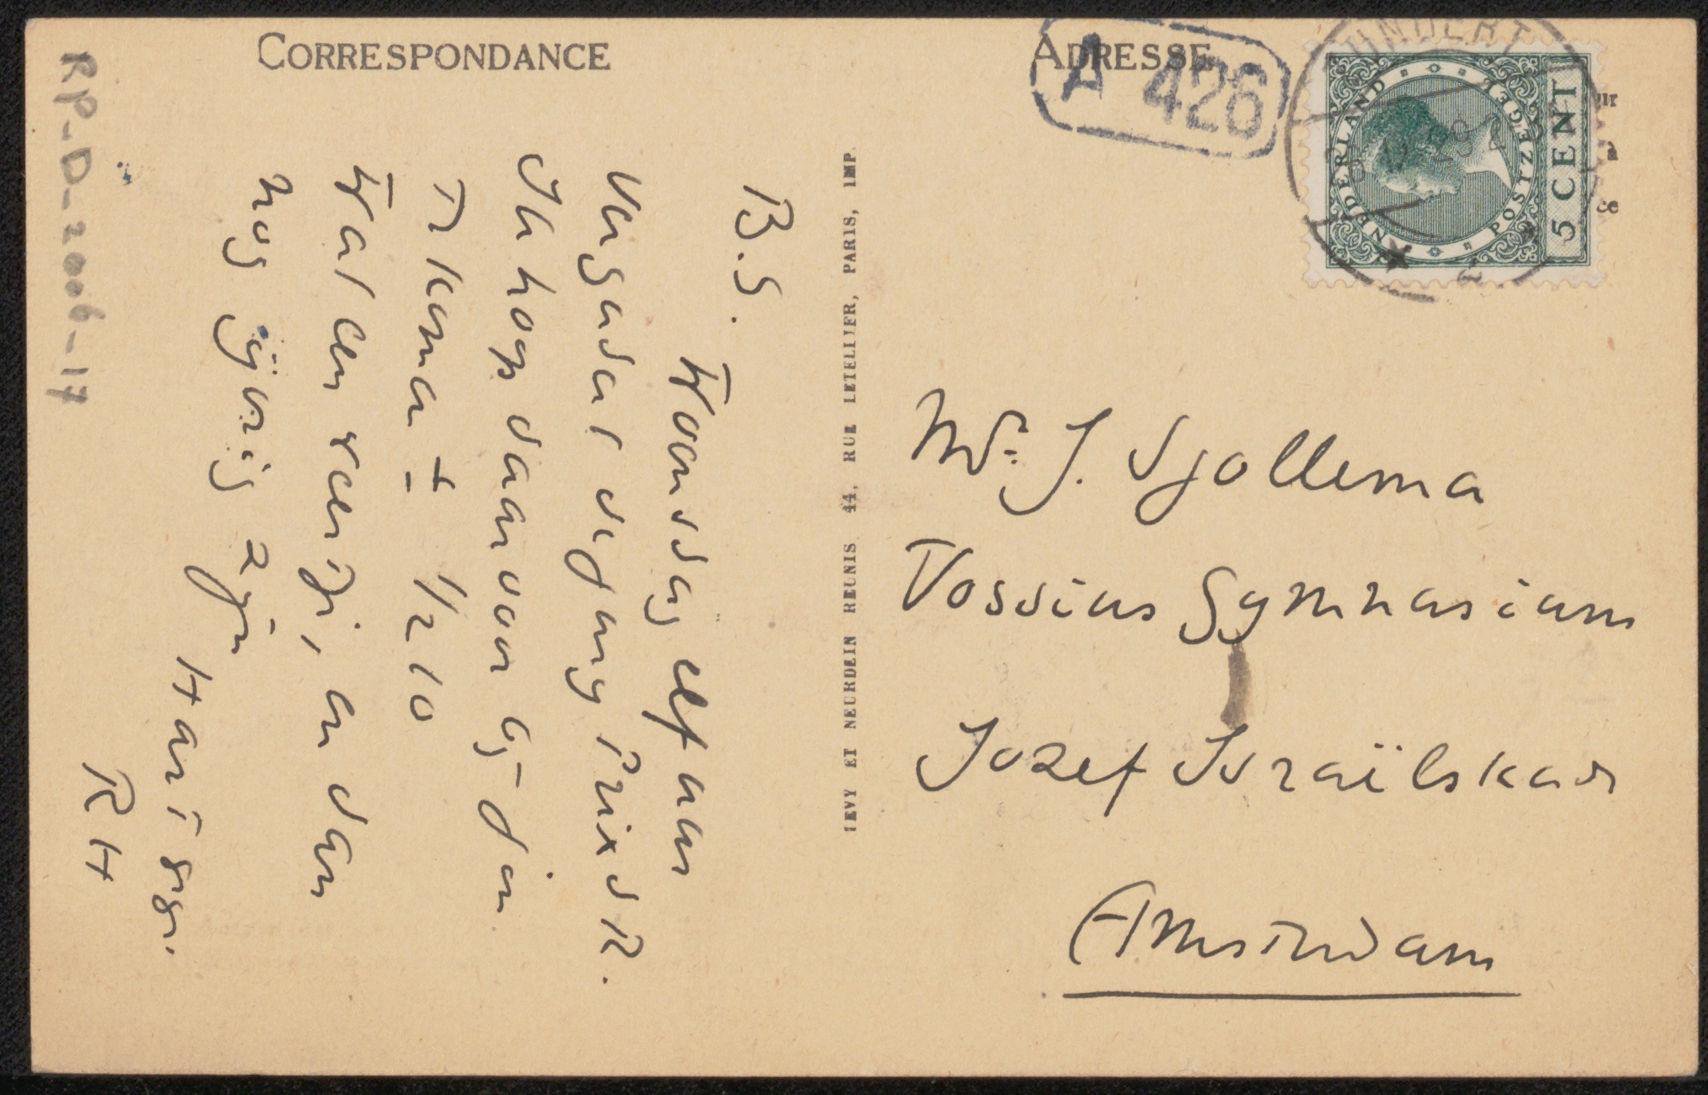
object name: ansichtkaart, prentbriefkaart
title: Prentbriefkaart aan Joop Sjollema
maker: richard nicolaüs roland holst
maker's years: 1868-1938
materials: cardboard, ink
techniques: pen, printing, writing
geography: zundert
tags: amsterdam, print maker, draughtsman, joop sjollema, distribution of awards ~ art contest